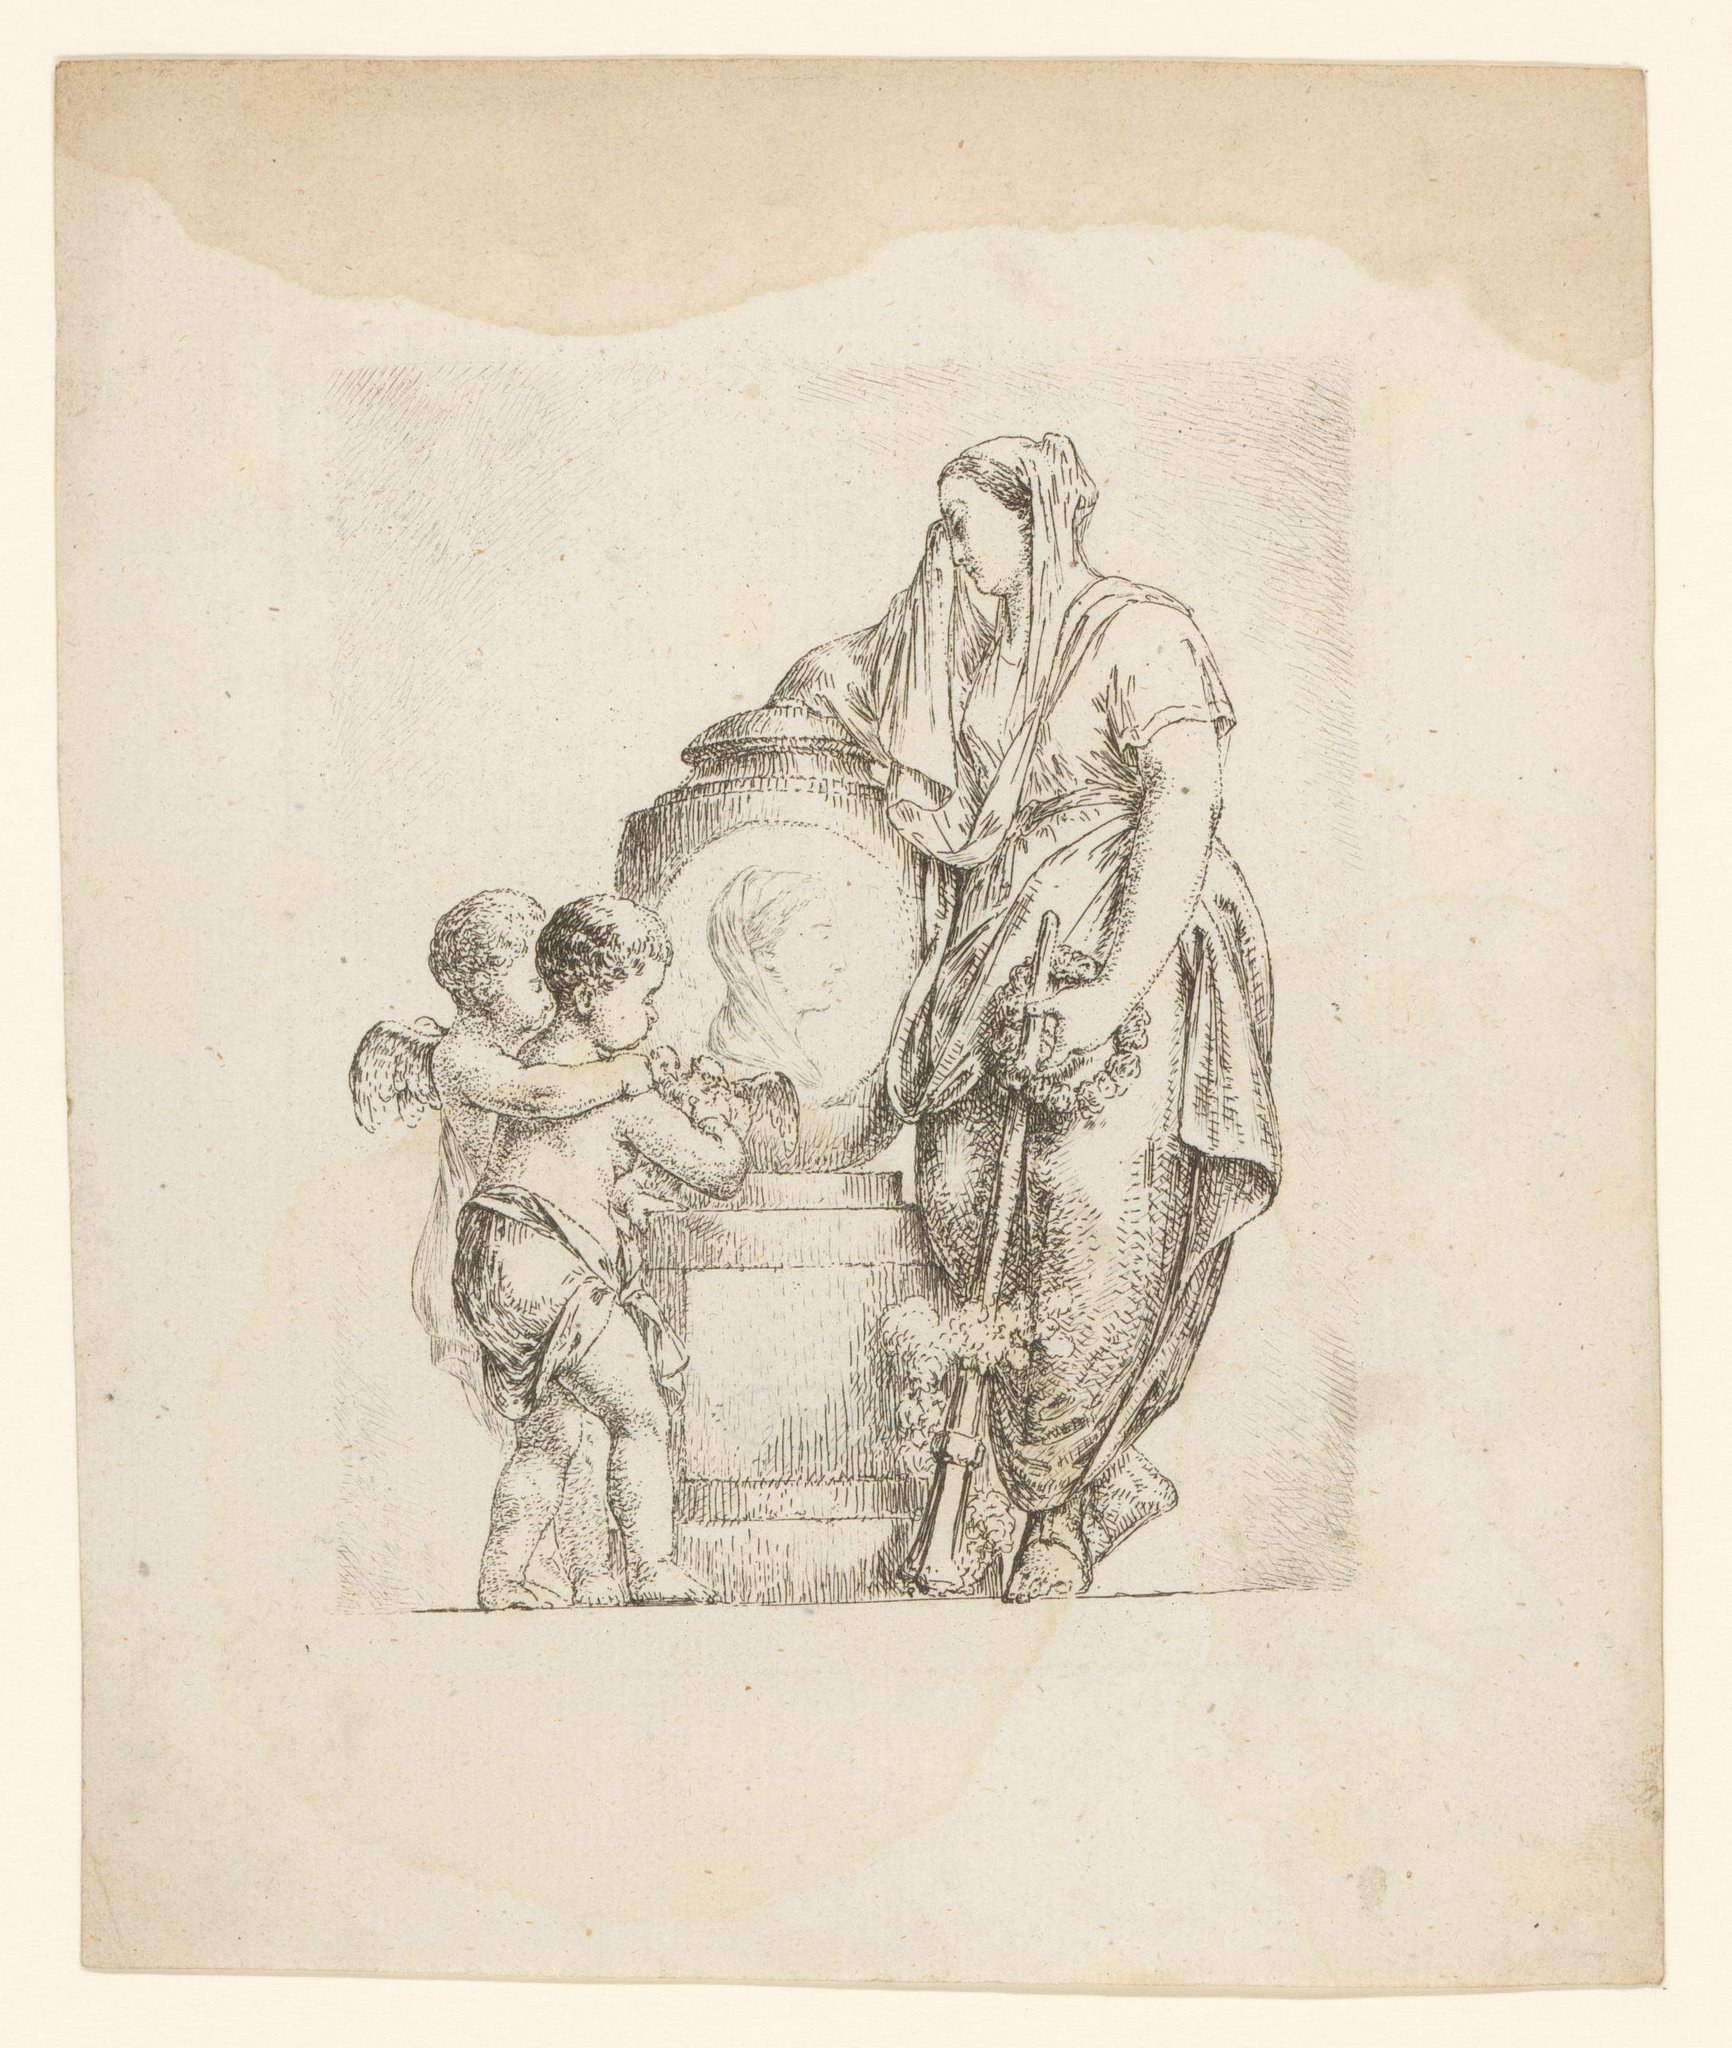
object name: print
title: Allegorie van de eeuwige liefde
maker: bernhard rode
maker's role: artist, print maker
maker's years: 1725-1797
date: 1788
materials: paper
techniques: etching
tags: love: 'frau minne' and other allegories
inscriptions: collector's mark: Lugt 2228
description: Prent ook gebruikt in: Ramler, Karl Wilhelm. Allegorische Personen zum Gebrauche der bildenden Künstler. Berlijn: Akademischen Kunst- und Buchhandlung, 1788.